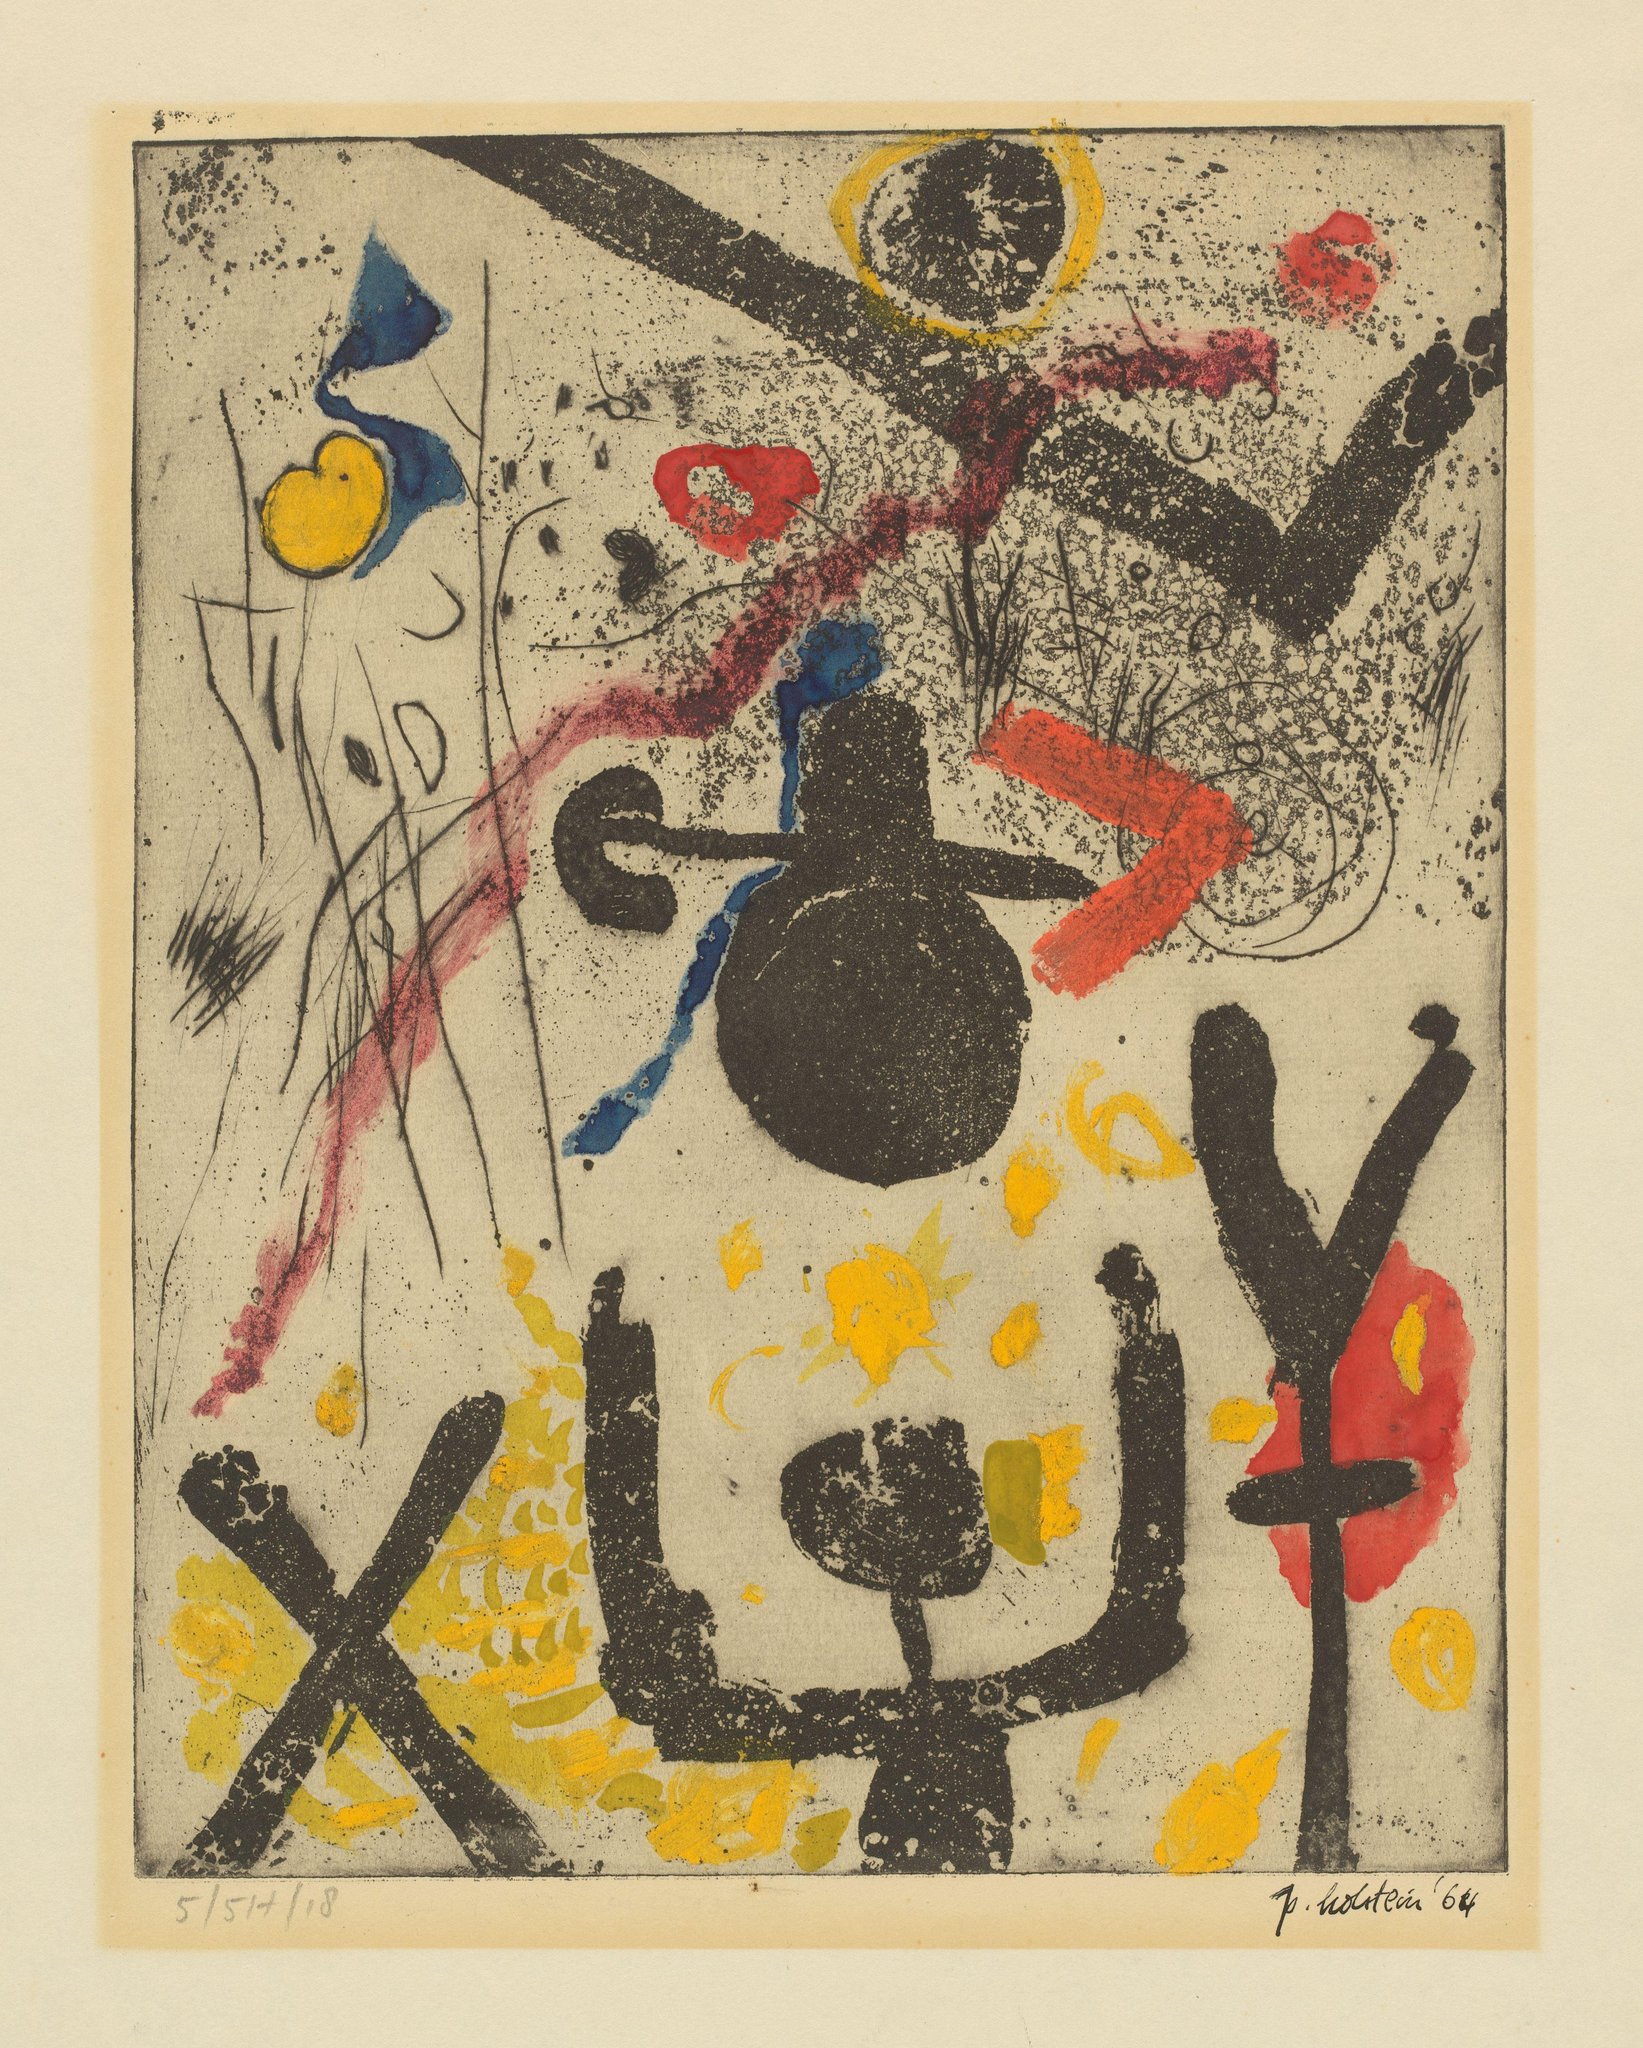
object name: print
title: Compositie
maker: pieter holstein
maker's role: draughtsman, painter, print maker, sculptor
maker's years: 1934-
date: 1964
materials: gouache, paper, ink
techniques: aquatint, brush, etching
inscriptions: signature and date: ‘p. holstein '64’, number: ‘5/5H/18’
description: Compositie in blauw, geel, rood en zwart met onderin een figuur met geheven armen, links daarvan een 'X' en rechts en 'Y'.